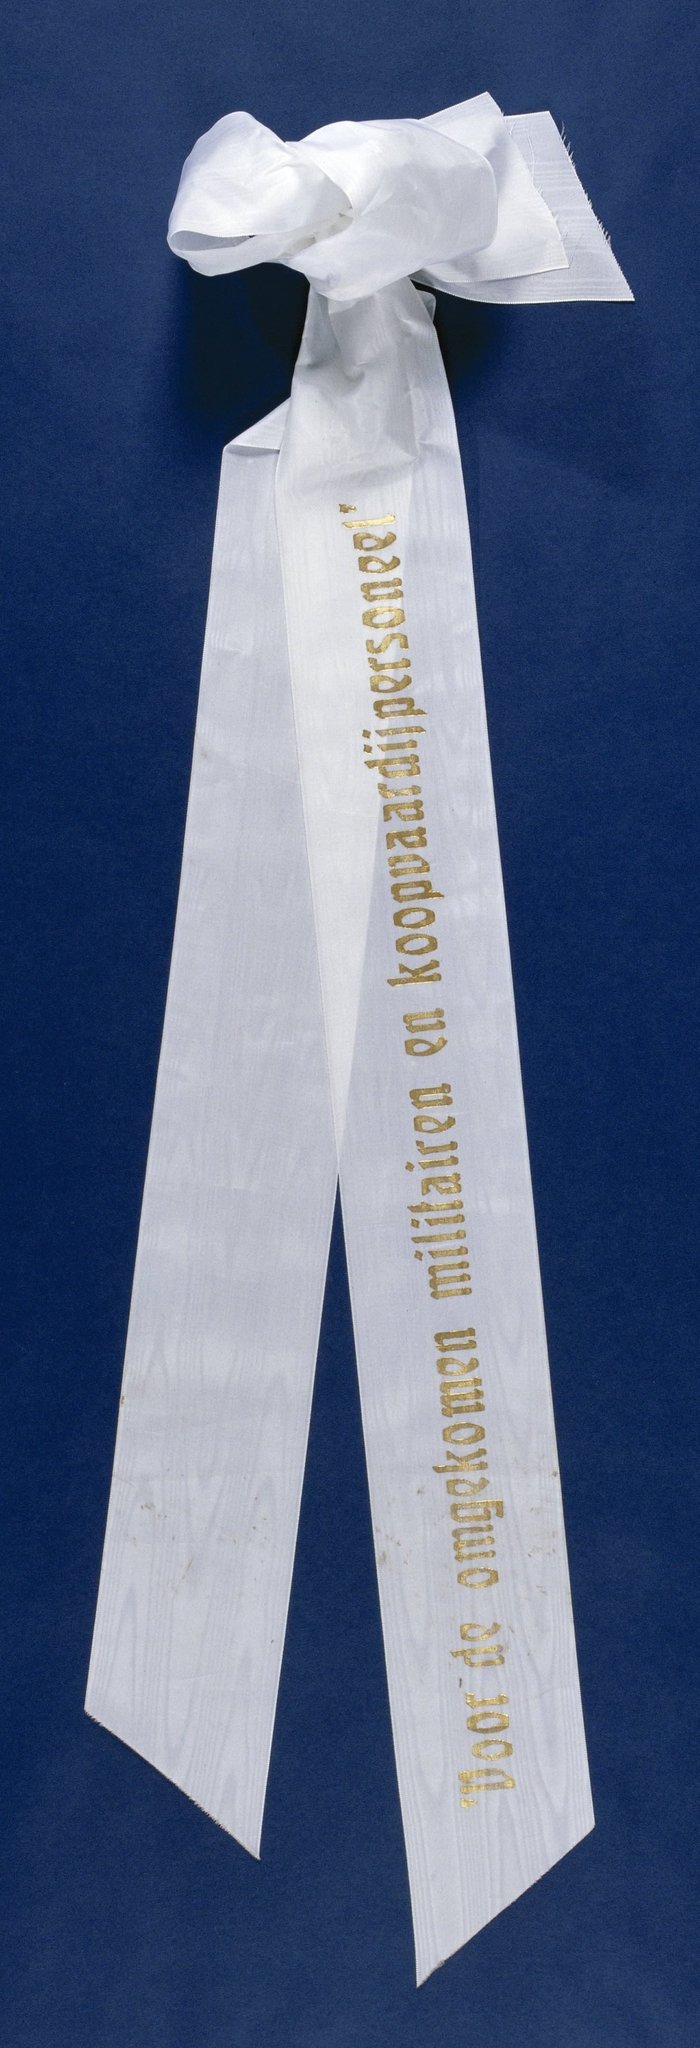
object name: ribbon material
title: Lint 'Voor de omgekomen militairen en koopvaardijpersoneel'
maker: Anonymous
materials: gold leaf, textile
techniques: printing, weave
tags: amsterdam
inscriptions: inscription: ‘'Voor de omgekomen militairen en koopvaardijpersoneel'’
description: Twee aan elkaar gebonden witte linten, gelegd op 4 mei 2000 bij het Nationaal Monument op de Dam. Het bovenste lint is v.z.v. een gouden opdruk. Onderste lint is blanco. Linten zijn aan de uiteinden schuin afgeknipt. Aan een zijde tot strik samengebonden met ijzerdraad. IJzerdraad gebogen t.b.v. bevestiging aan krans.